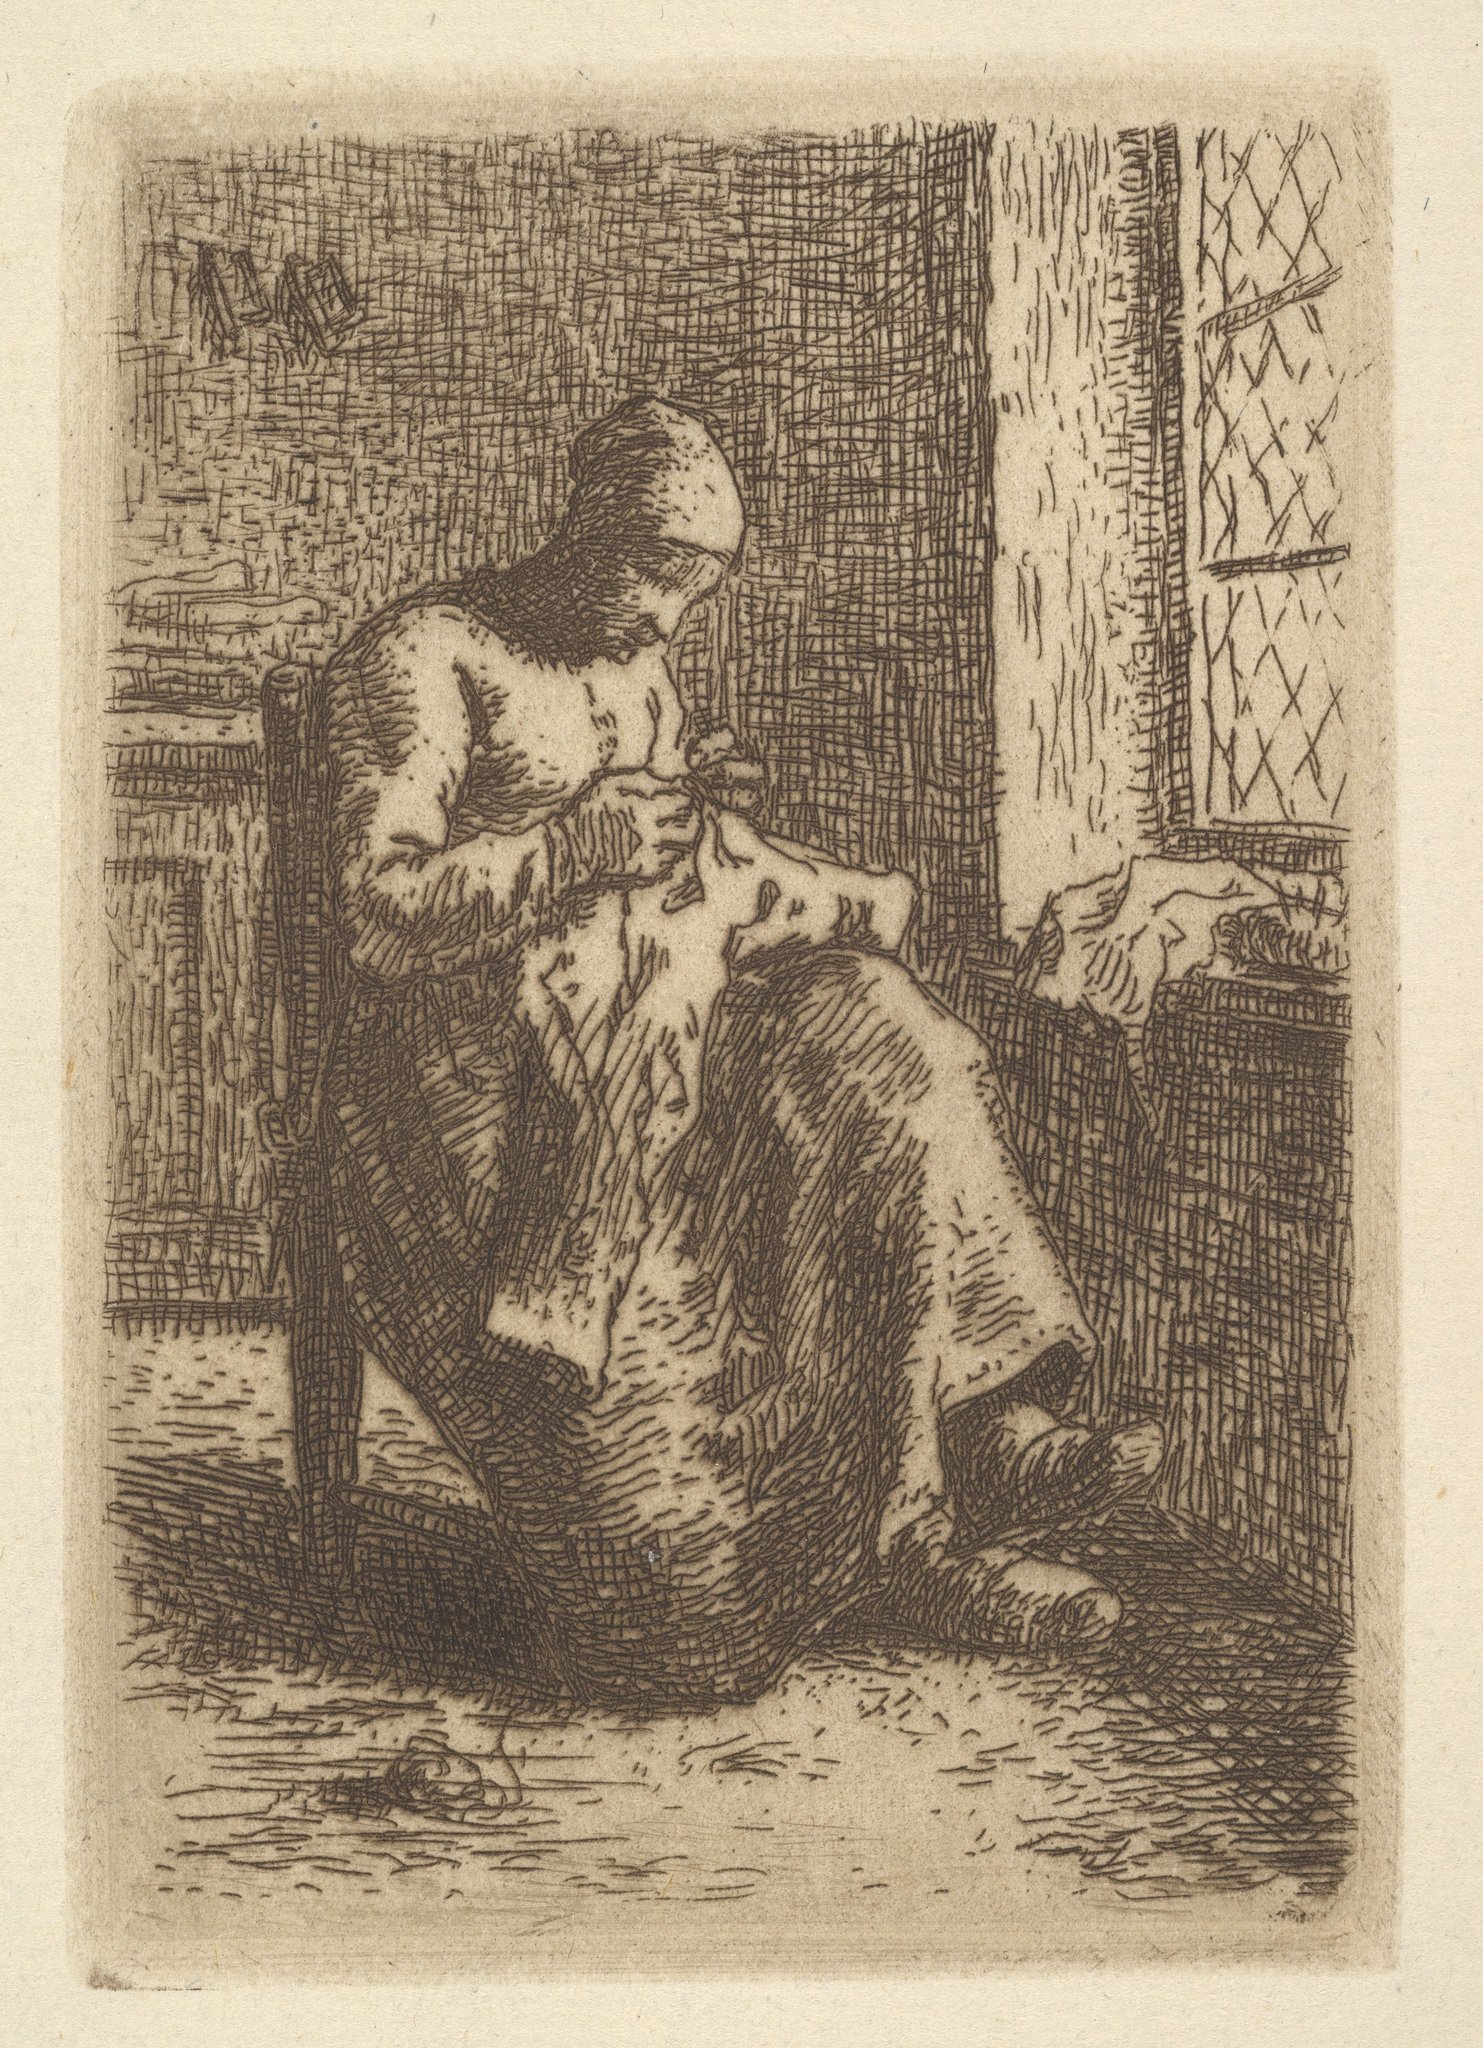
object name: print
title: The Sewer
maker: jean-françois millet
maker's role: artist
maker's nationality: french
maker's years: 1814-1875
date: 1855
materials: ink, paper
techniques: etching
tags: women,working